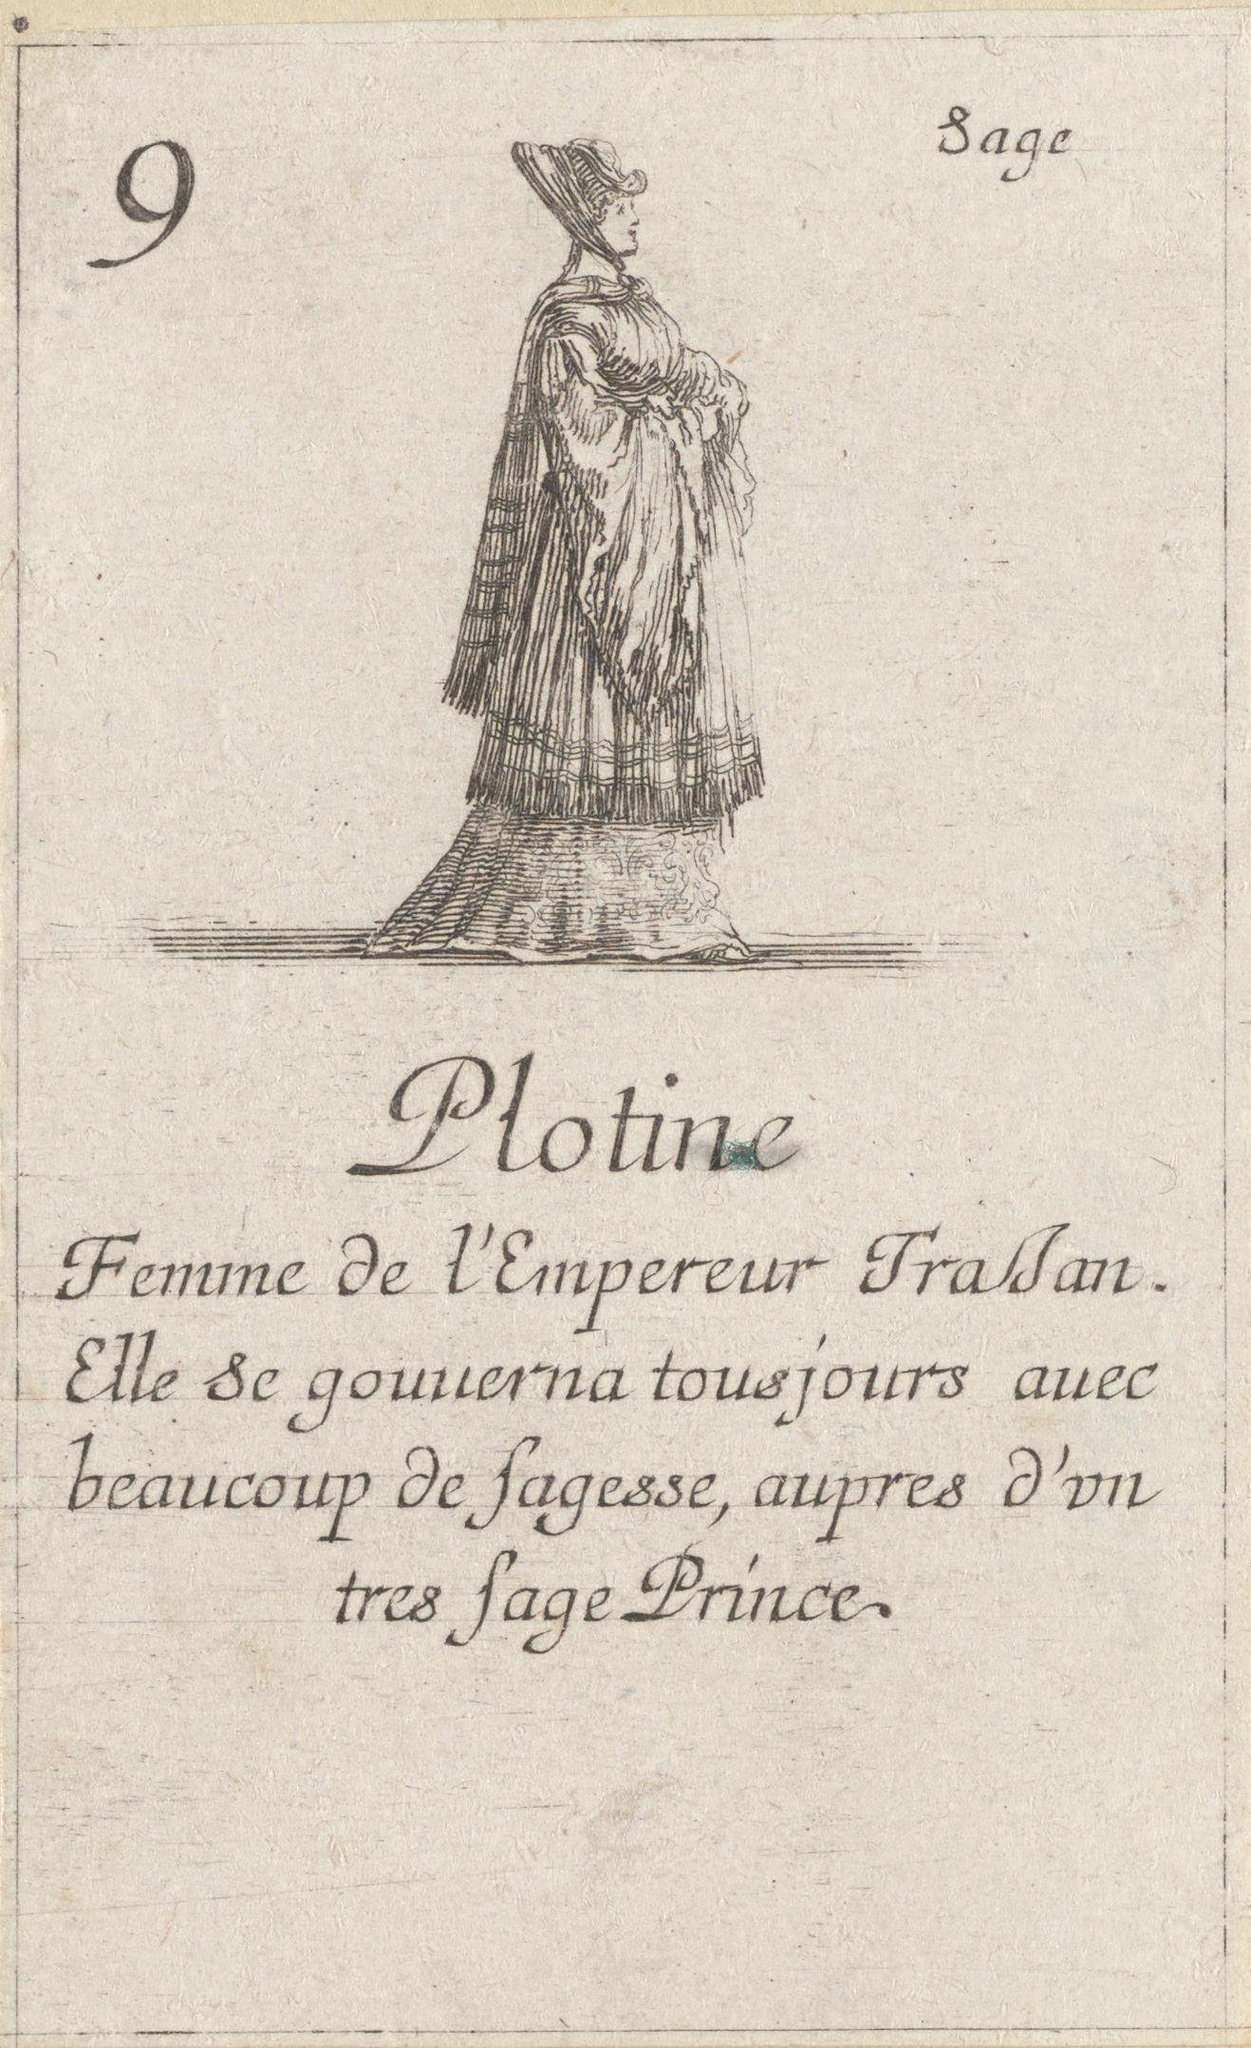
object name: print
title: Plotine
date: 1620-1664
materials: paper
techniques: etching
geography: paris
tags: ruler, sovereign - bb - female ruler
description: Deze prent maakt deel uit van een kaartspel met 52 kaarten met voorstellingen van beroemde koninginnen. De serie is uitgedacht door Jean Desmarests de Saint-Sorlin in opdracht van Kardinaal Mazarin. Het kaartspel werd gemaakt voor de jonge Lodewijk XIV, samen met het Jeu des Fables, Jeu de la Géographie en Jeu des Rois de France.